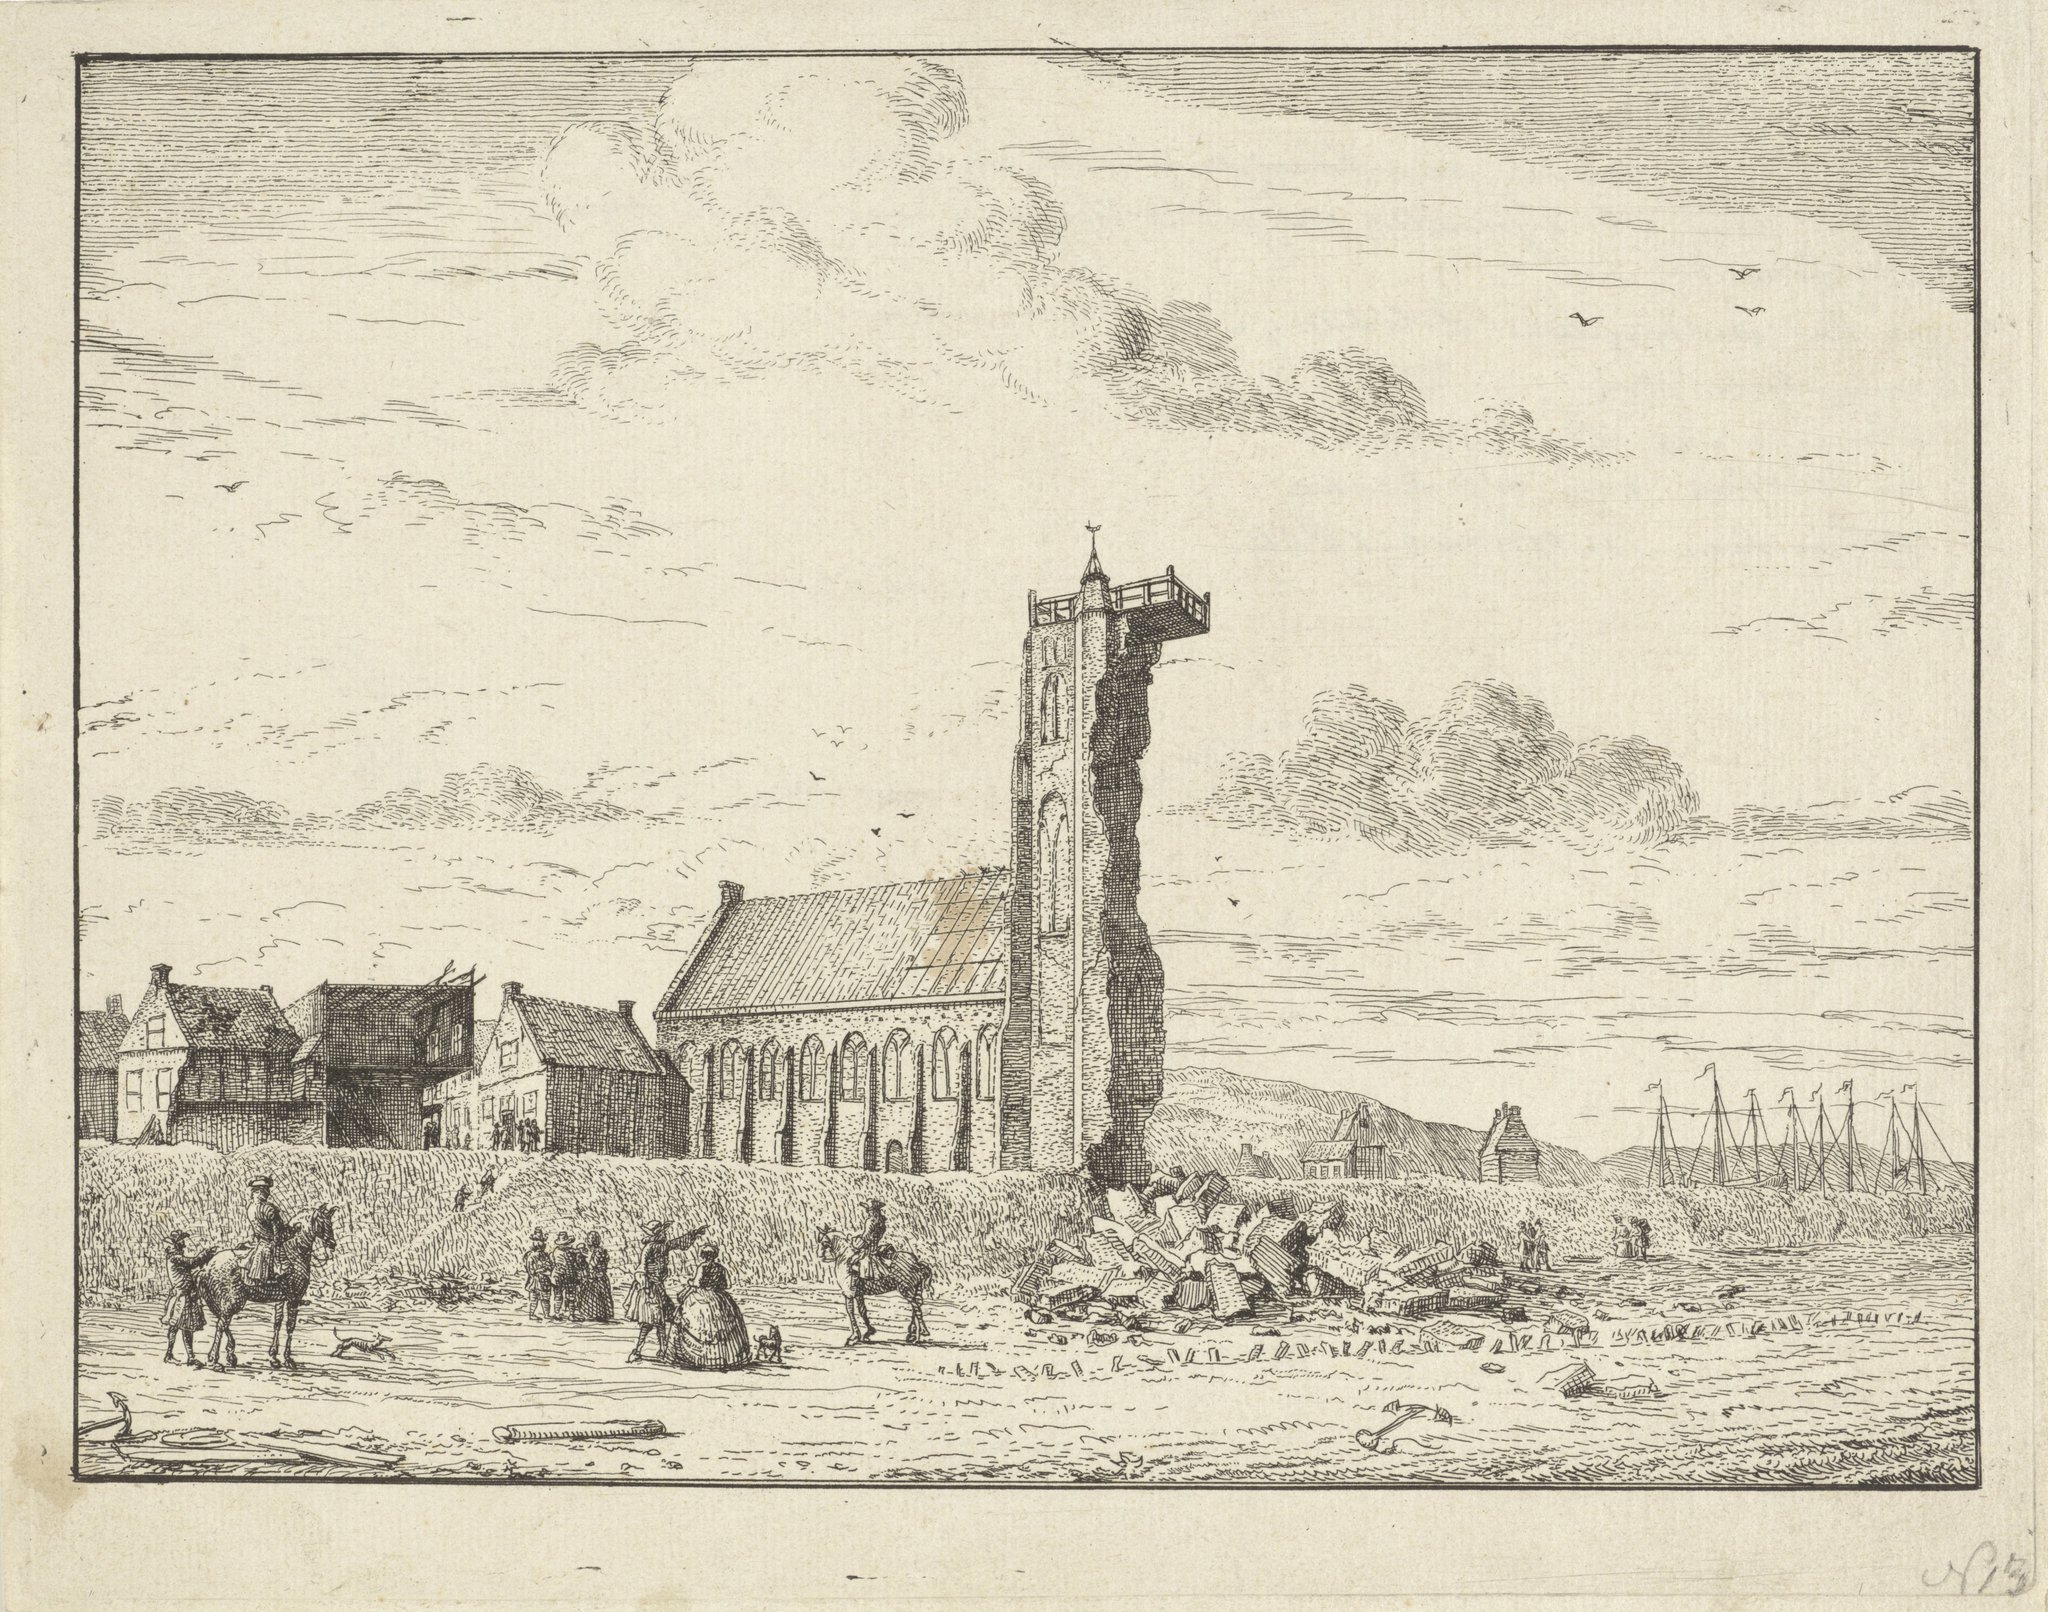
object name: print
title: Ingestorte toren te Egmond aan Zee, 1741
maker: adriaan spinder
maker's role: draughtsman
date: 1741-1743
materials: paper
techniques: etching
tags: ruin of a building ~ architecture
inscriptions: collector's mark: Lugt 2228, inscription: ‘pag 52 Omsdlag 28/ Waarin de afbeelding van de toren en kerk te Egmond/ op Zee, door A. Spinder en I.vd Vinne, met de beschrijving./ 22 afdrukken/ Zie Cat der Schilderijen enz/ nagelaten door Vindent vd Vinnen/ en Willem van Oukerke/ Haarlem 11 Maart 1816.’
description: Gezicht op de ingestorte toren te Egmond aan Zee, op 27 november 1741. Op het strand brokstukken en toeschouwers.